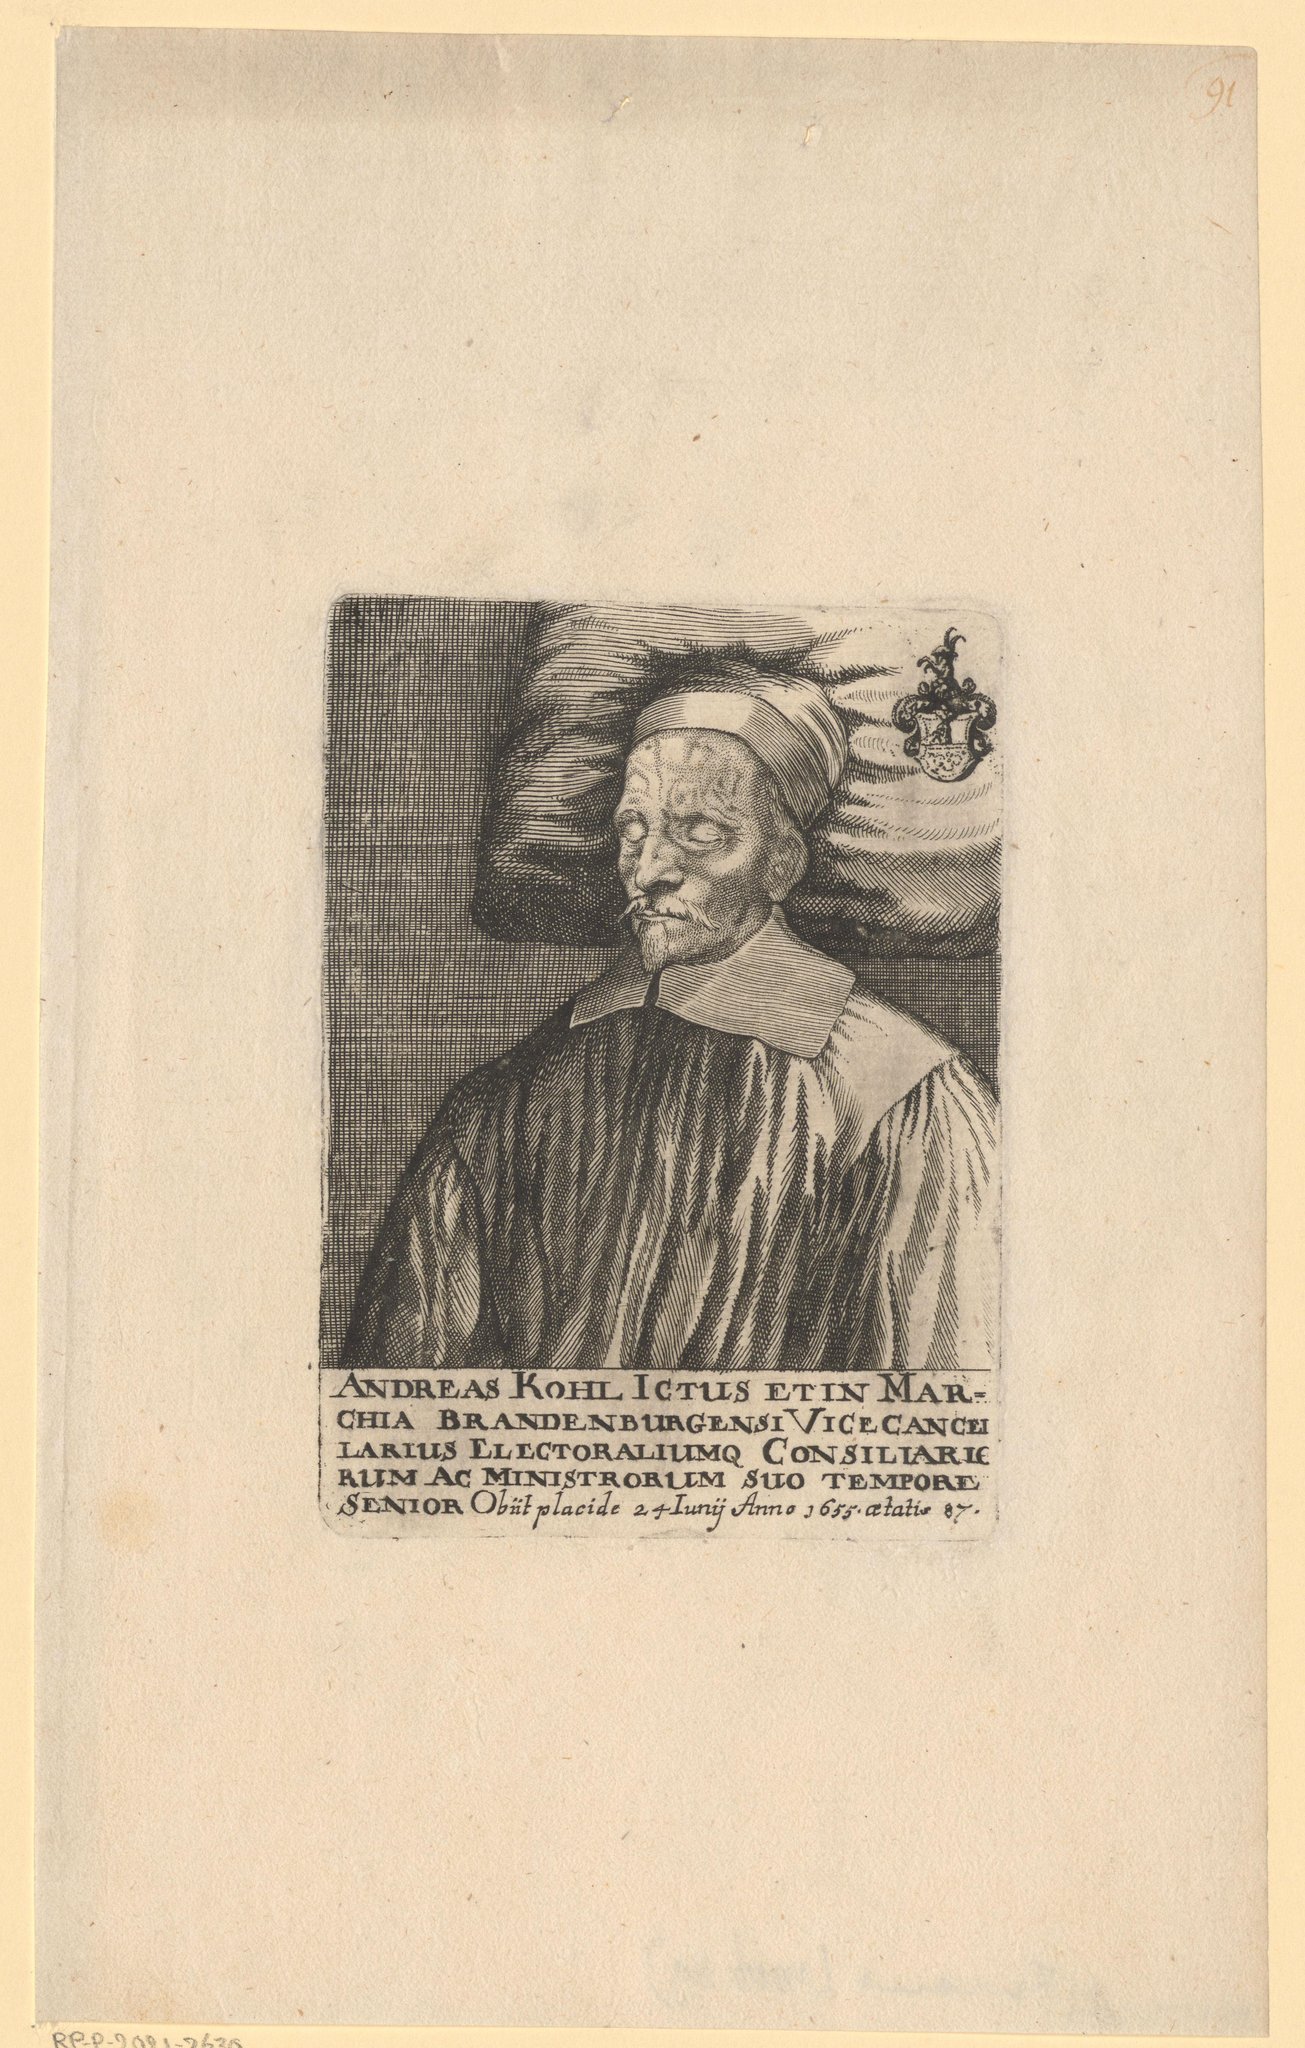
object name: print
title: Illustere mannen verzameld door Martin Friedrich Seidel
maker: Anonymous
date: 1751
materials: paper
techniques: engraving, etching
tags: print maker, andreas kohl, historical persons, armorial bearing, heraldry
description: De prent is uitgegeven als onderdeel van een serie. Later is de prent mogelijk ook als boekillustratie gebruikt in: Küster, Georg Gottfried. Martin Friedrich Seidels Bilder-Sammlung in welcher hundert, gröstentheils in der Mark Brandenburg (…). Berlijn: Buchladen bey der Real-Schule, 1751. Het is onduidelijk tot welke uitgave de huidige prent behoort.